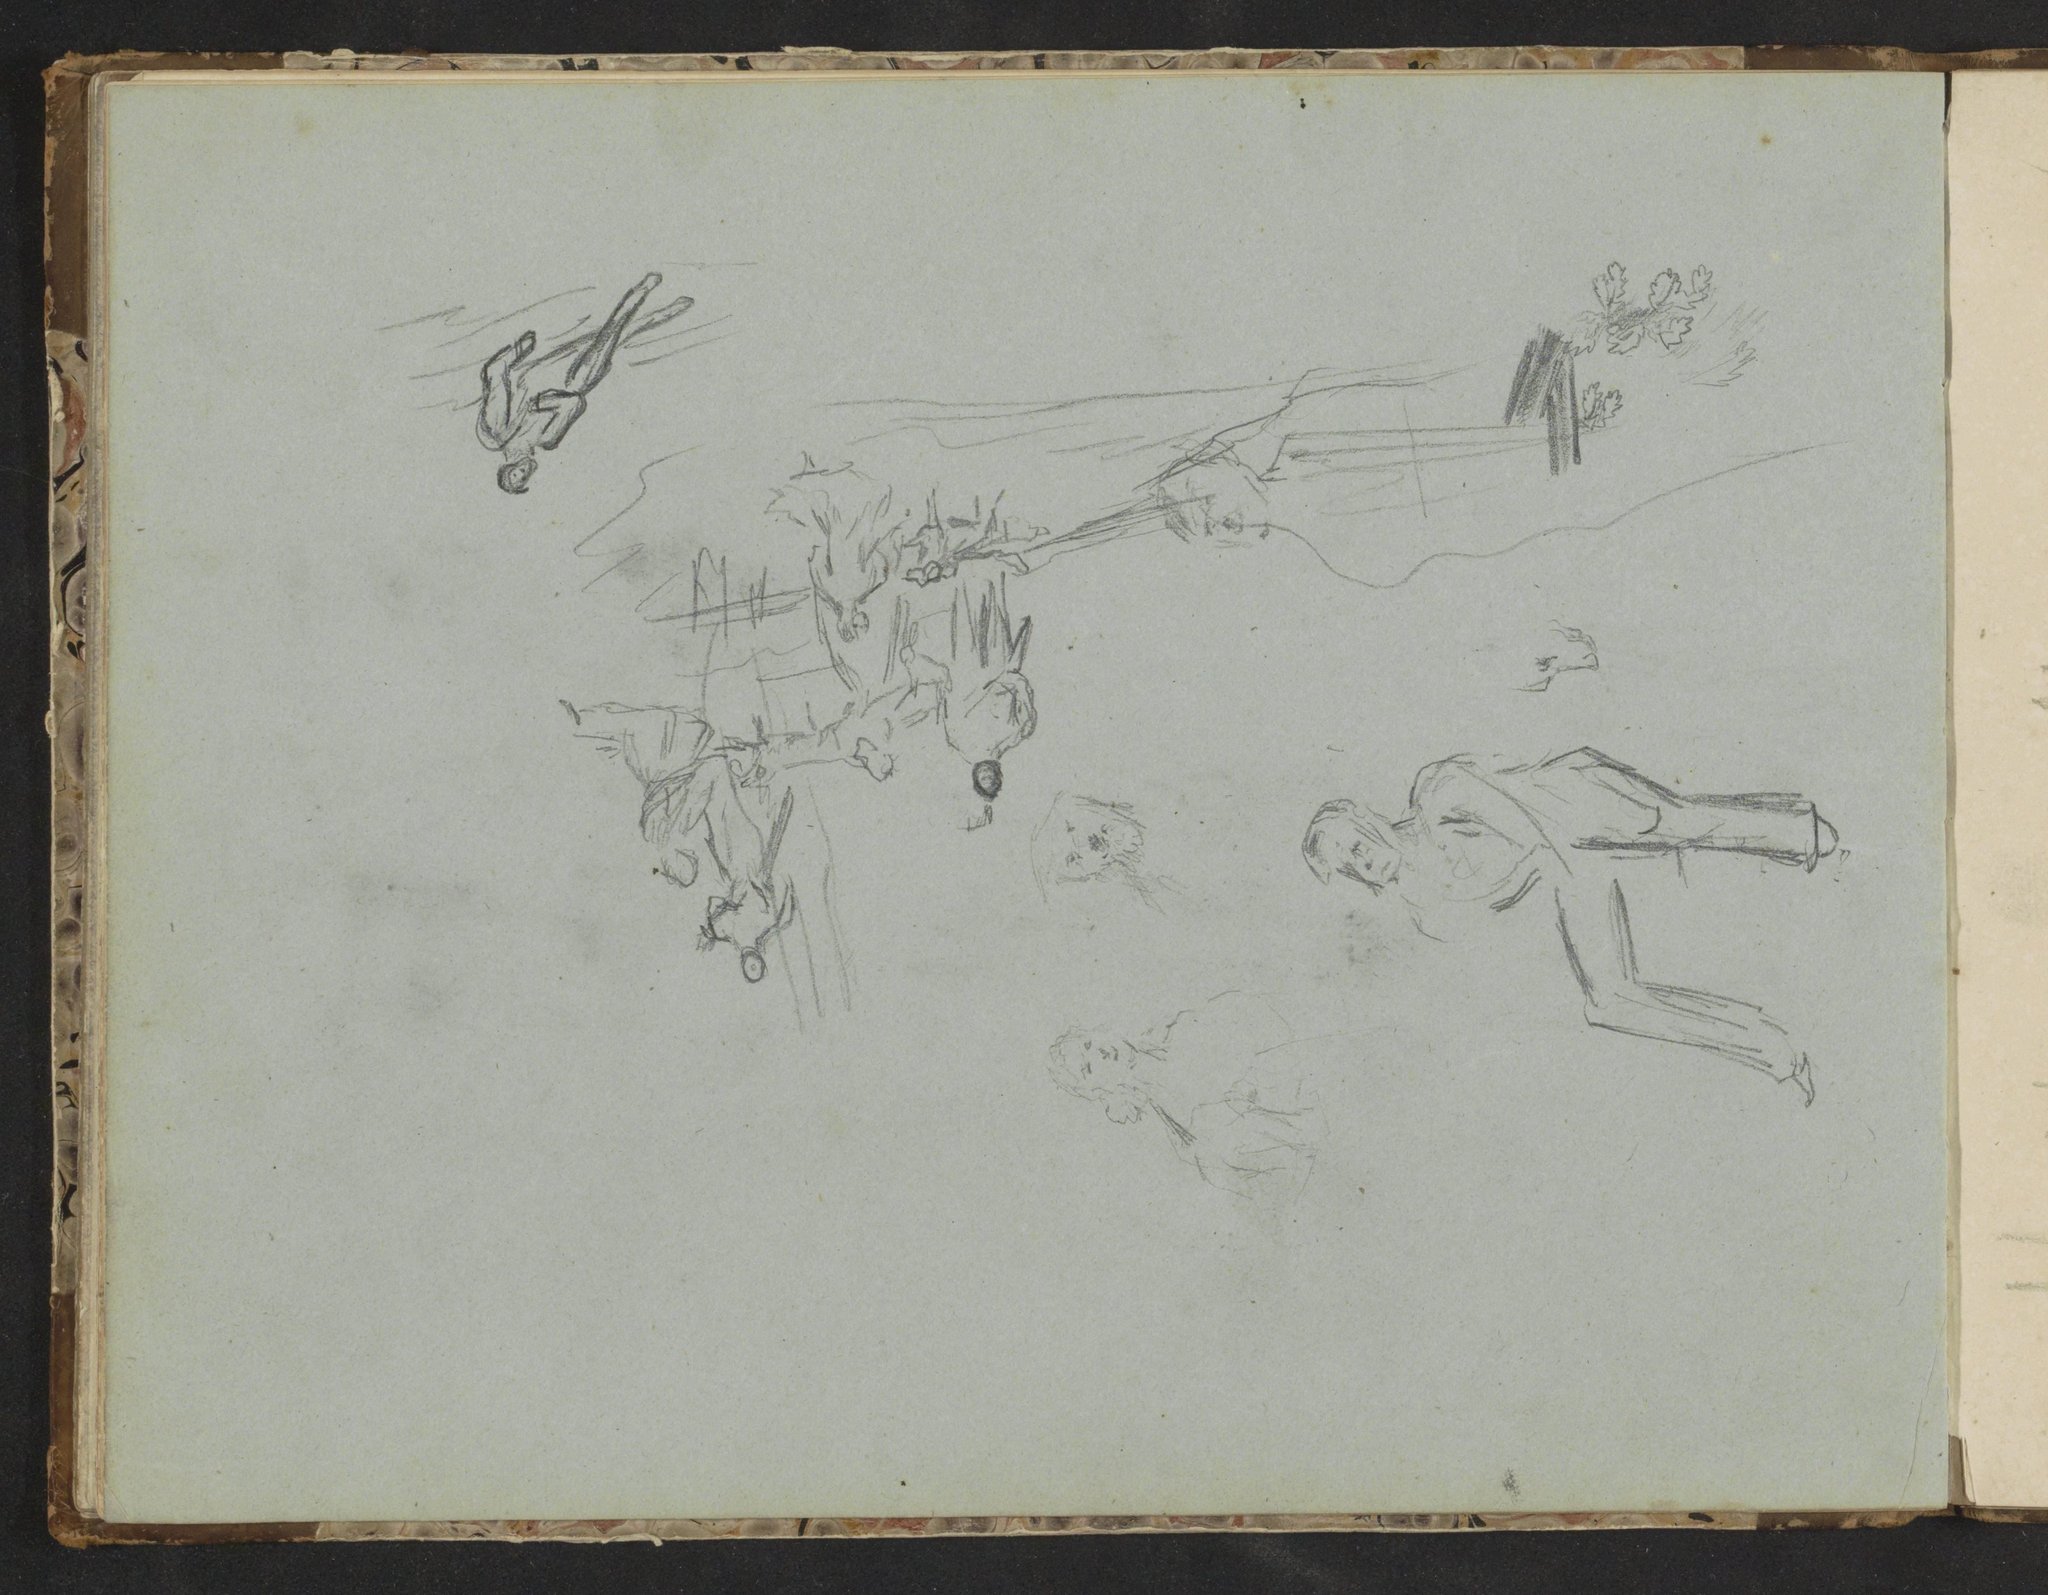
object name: sketchbook leaf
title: Figuurstudies en honden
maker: johannes tavenraat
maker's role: draughtsman, painter, print maker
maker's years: 1809-1881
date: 1833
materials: paper, pencil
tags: anatomy (non-medical), dog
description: Op de voorgrond de moestuin van het landgoed. Blad 13 verso uit een schetsboek met 41 bladen.